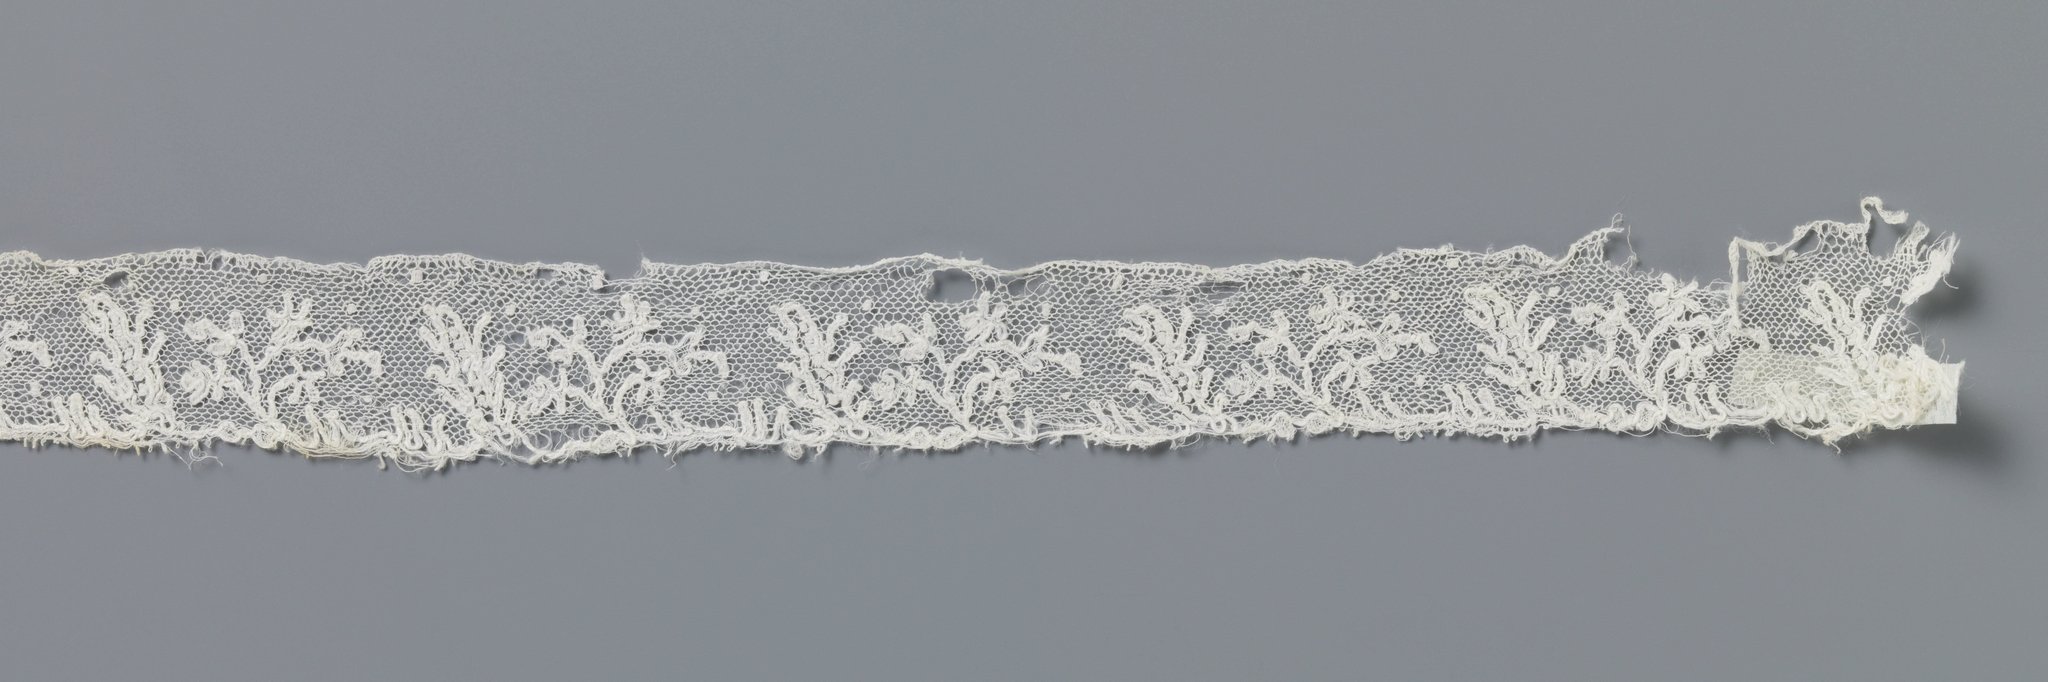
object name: strip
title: Strook kloskant met takje met sterbloempjes en dik takje met zijtakjes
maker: Anonymous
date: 1840-1850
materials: linen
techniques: lace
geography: lille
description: Strook naturelkleurige kloskant: Rijselse kant. Tussen gestrooide moesjes bestaat het herhalende patroon uit twee verschillende ijle takjes, die ontspringen aan de onderzijde van de strook. Aan de ene tak zitten enkele stervormige bloempjes, de andere tak heeft een dikke basis met aan weerszijden dunne korte takjes. De motieven zijn met elkaar verbonden door een fijne traliegrond, een tulegrond. Het zeer spaarzame volwerk is gemaakt in linnenslag, waarbij de dikkere en glimmende contourdraden overheersen. De dikkere tak is gevuld met gestapelde blokjes, gemaakt in vormslag. Boven- en onderzijde van de strook zijn recht afgewerkt, waarbij de onderzijde is voorzien van picots.